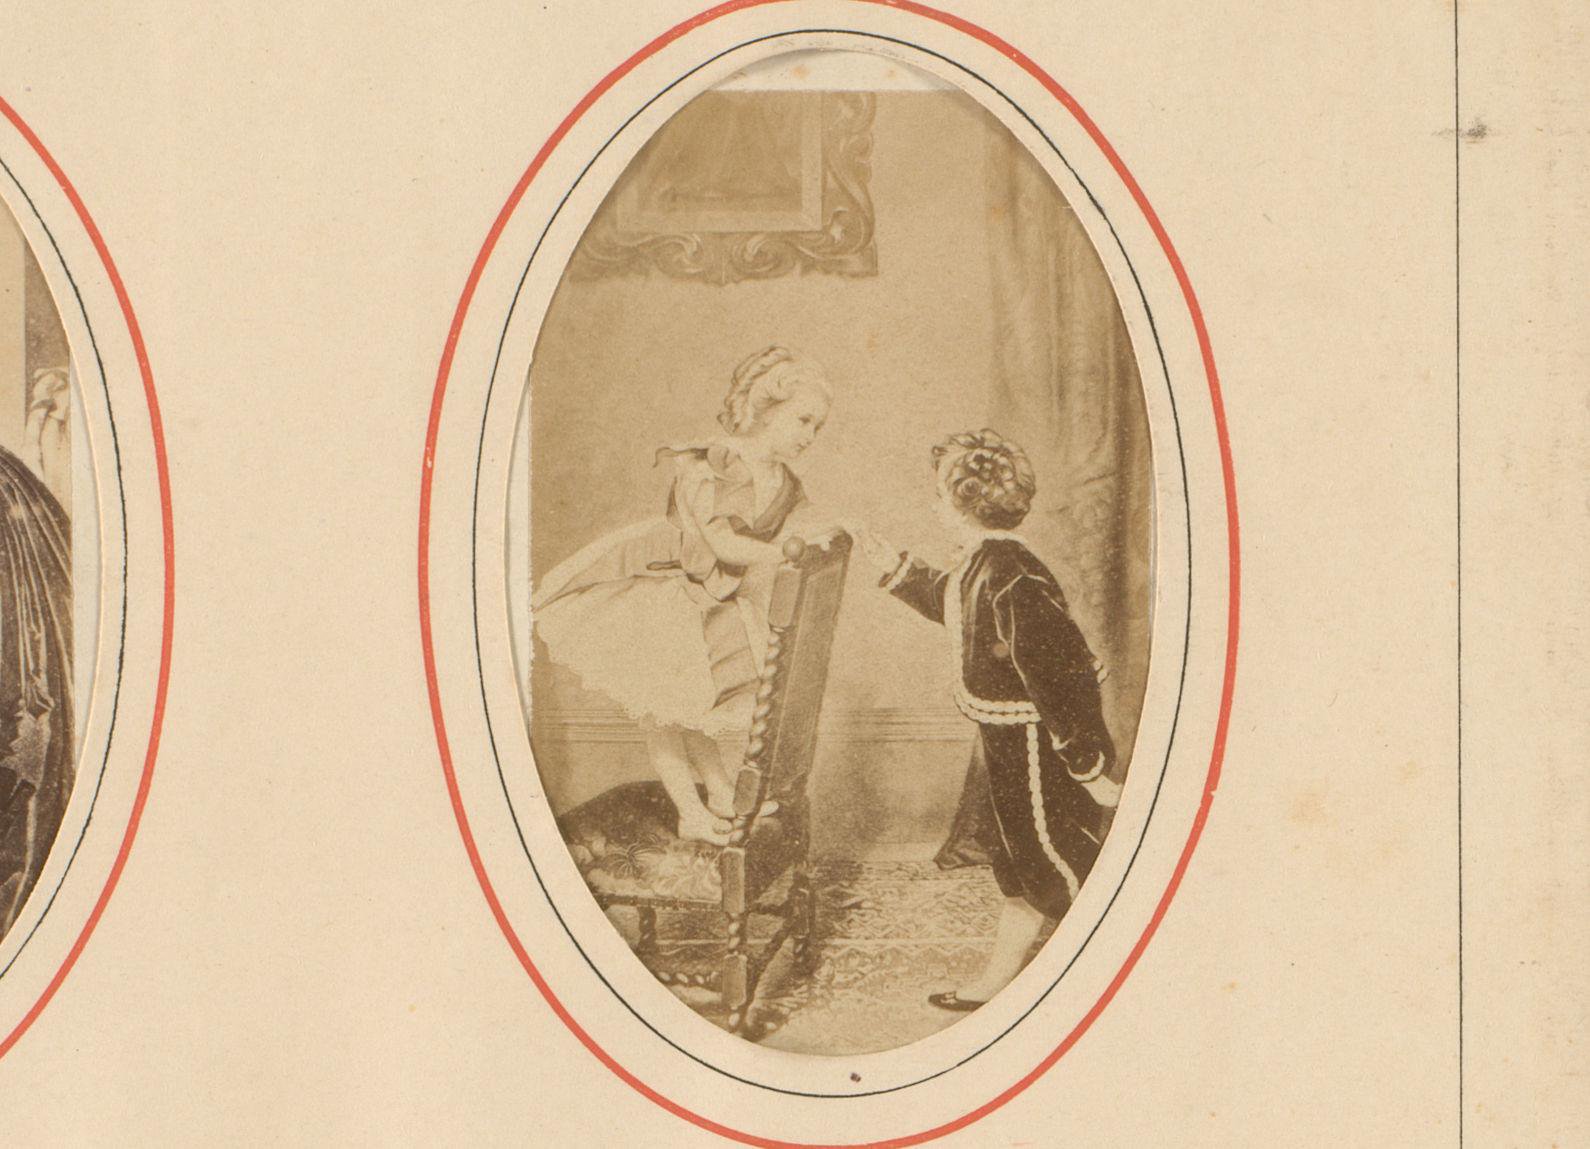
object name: album leaf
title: Fotoreproductie van een schilderij van Miss Lily met een jongen, door James Hayllar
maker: Anonymous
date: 1870-1890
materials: cardboard, paper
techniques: albumen print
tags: girl (child between toddler and youth)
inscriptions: number: ‘No 405.’